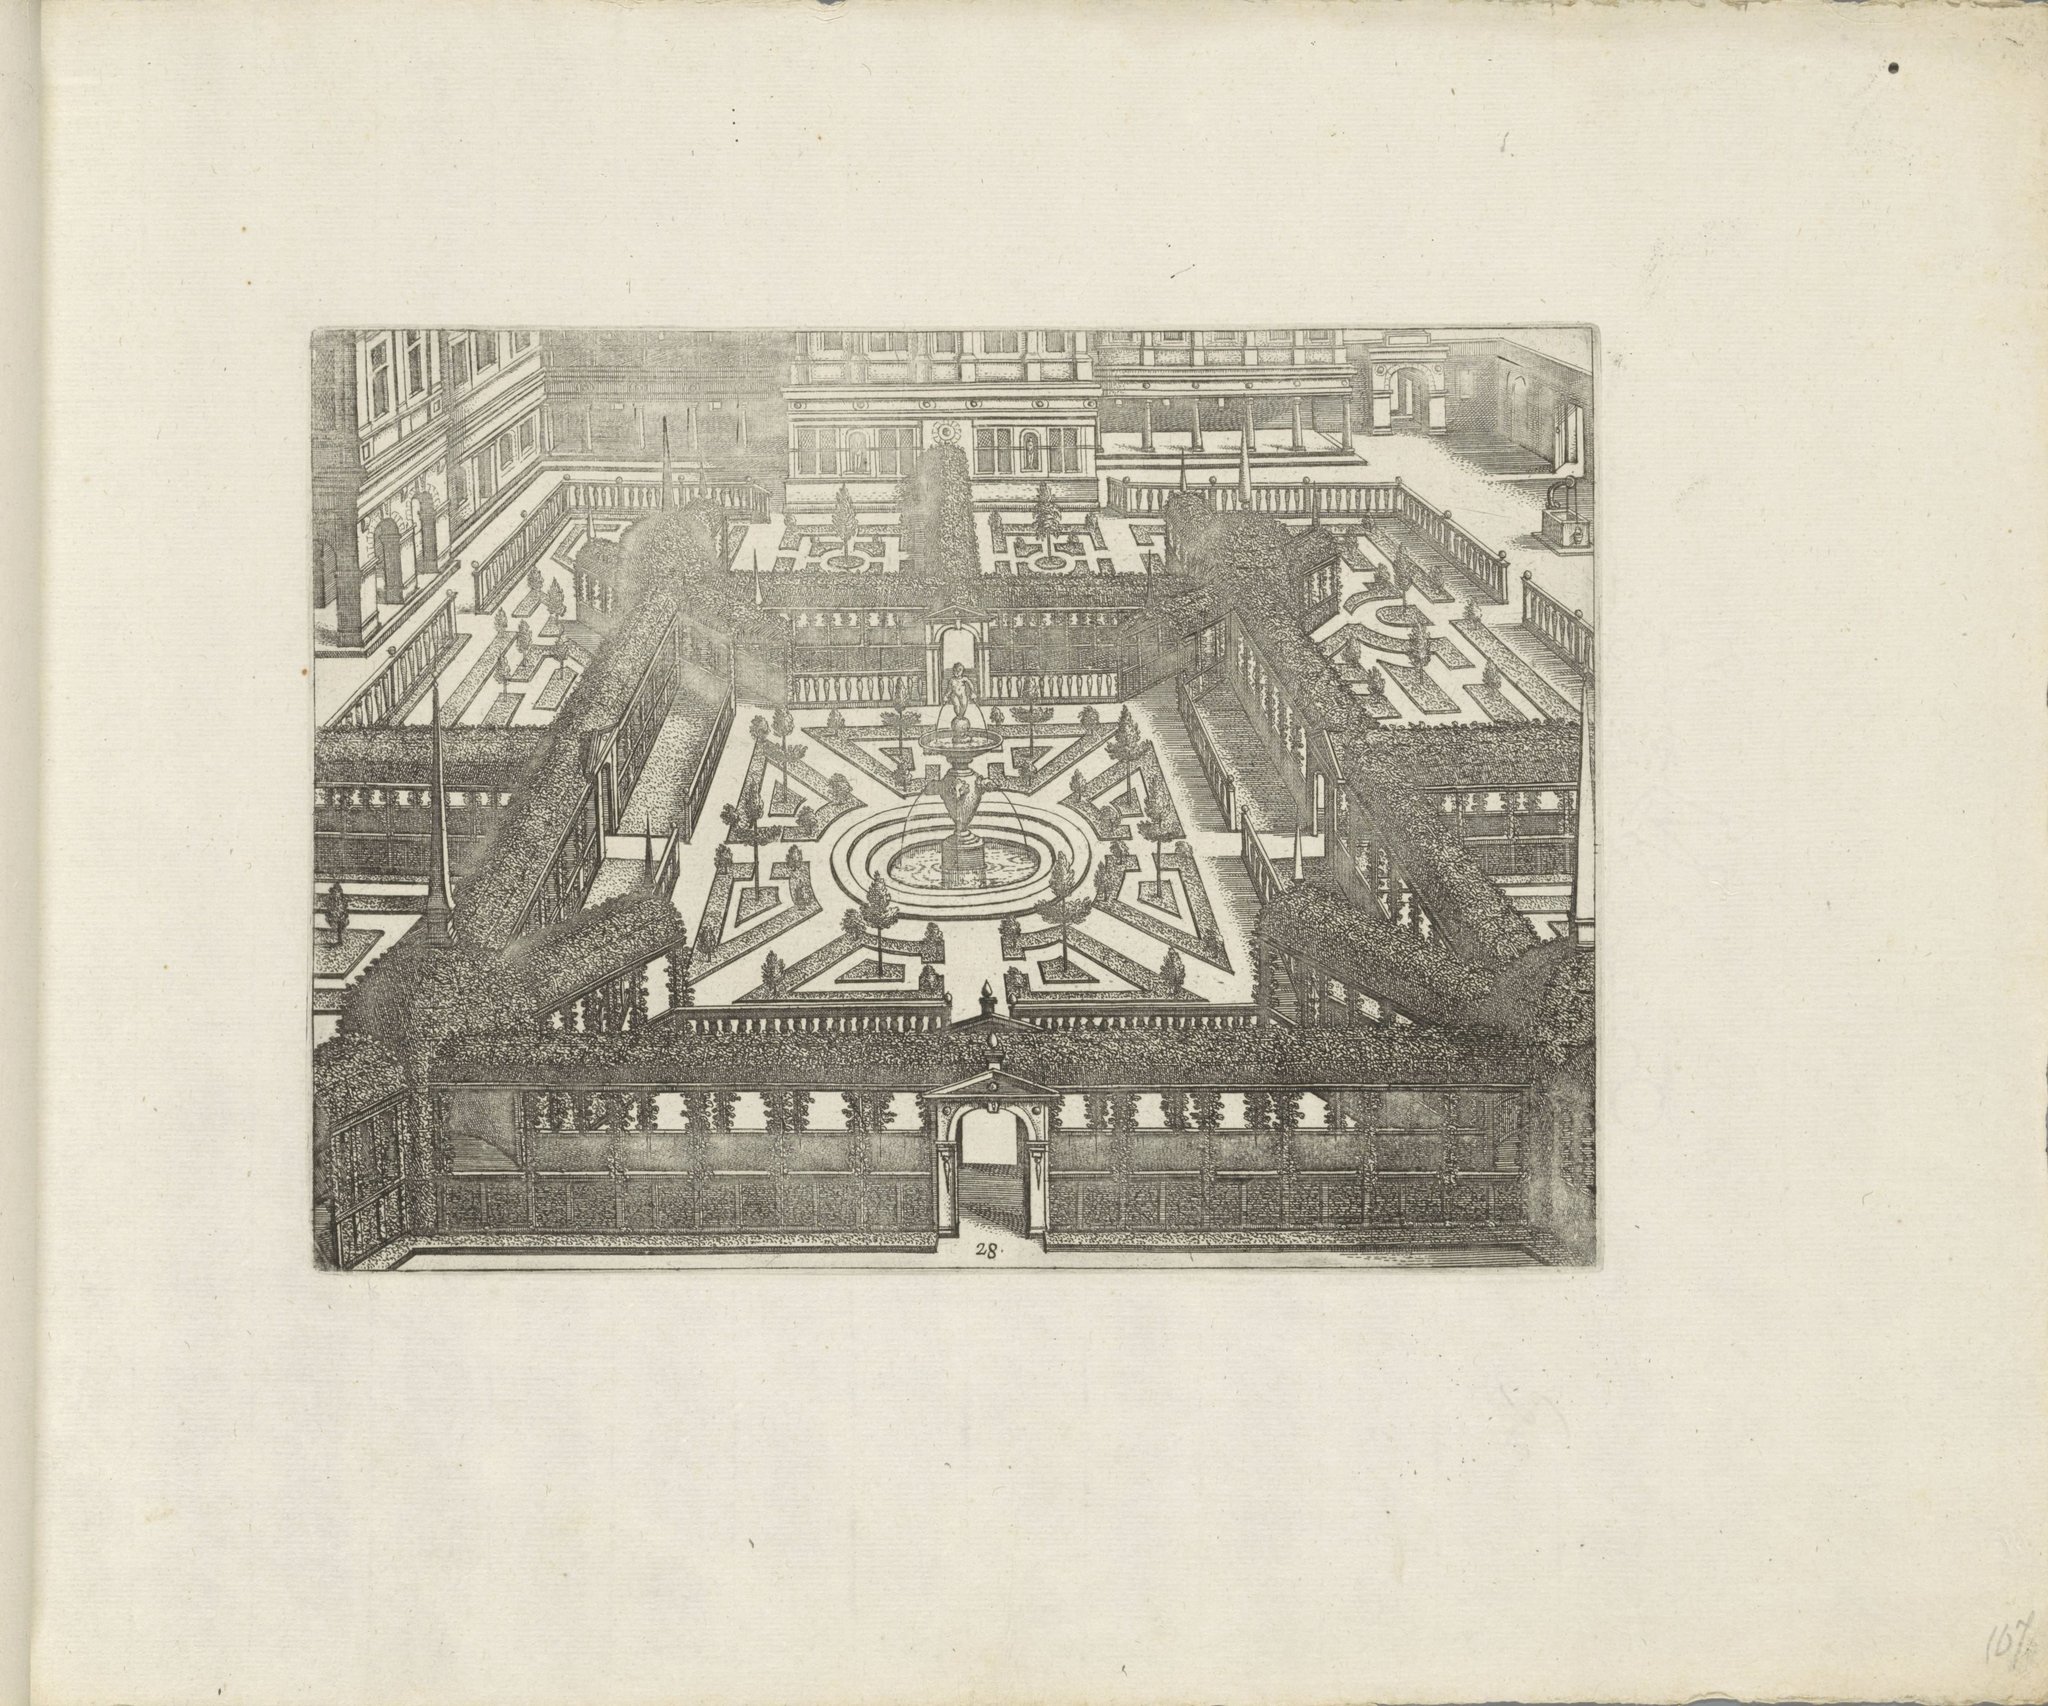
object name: print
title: Hortorum Viridariorumque (...)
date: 1587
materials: paper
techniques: etching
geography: antwerp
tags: garden, french or architectonic garden; formal garden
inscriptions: collector's mark: Lugt 2760, collector's mark: Lugt 2228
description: De serie ‘Hortorum Viridariorumque’ van Vredeman de Vries (Hollstein Dutch 470-490) is in deze editie van de serie door uitgever Joannes Galle ( en eerder door zijn voorganger Theodoor Galle) aangevuld met de serie ‘Tuinen’ van Vredeman de Vries (Hollstein Dutch 508-515) en met twee prenten van Pieter van der Borcht (I) (New Hollstein Dutch 161-162). De prenten zijn genummerd: 1-30. Origineel hoort bij deze editie van de serie, uitgegeven door Joannes Galle, nog een prent van Van der Borcht met nummer 31, maar deze prent ontbreekt in deze serie in de collectie van het Rijksmuseum.